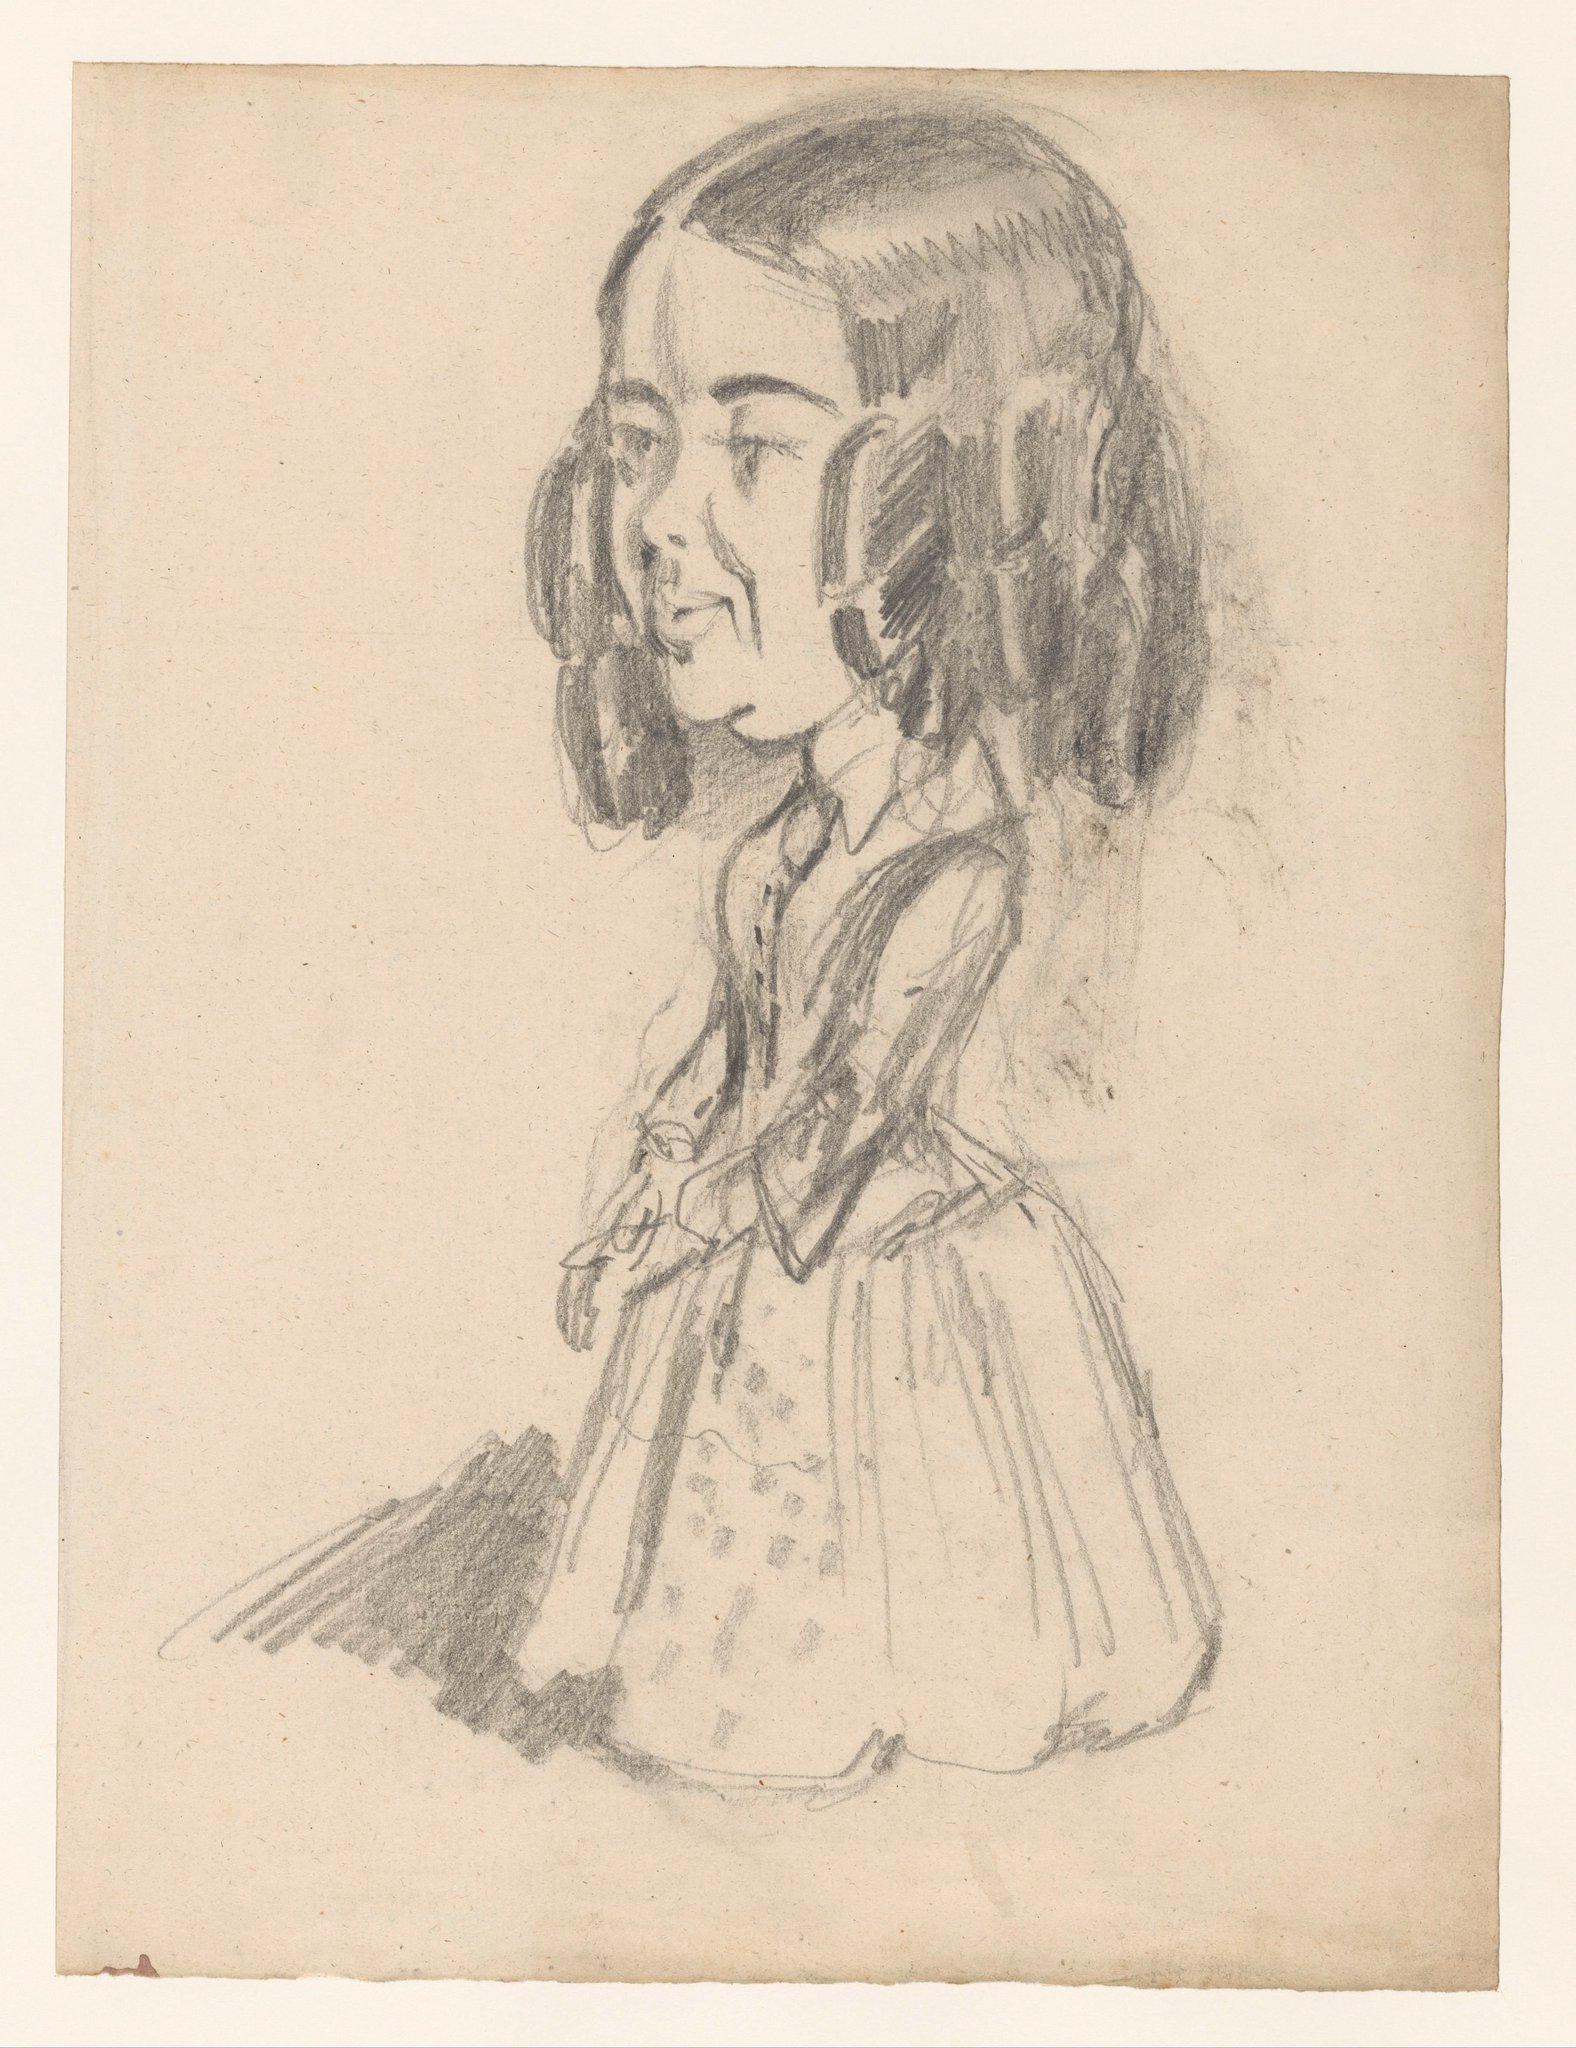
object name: drawing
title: Karikatuur van een staande vrouw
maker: pieter van loon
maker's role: draughtsman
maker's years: 1801-1873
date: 1811-1873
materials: paper, pencil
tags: caricatures (human types)